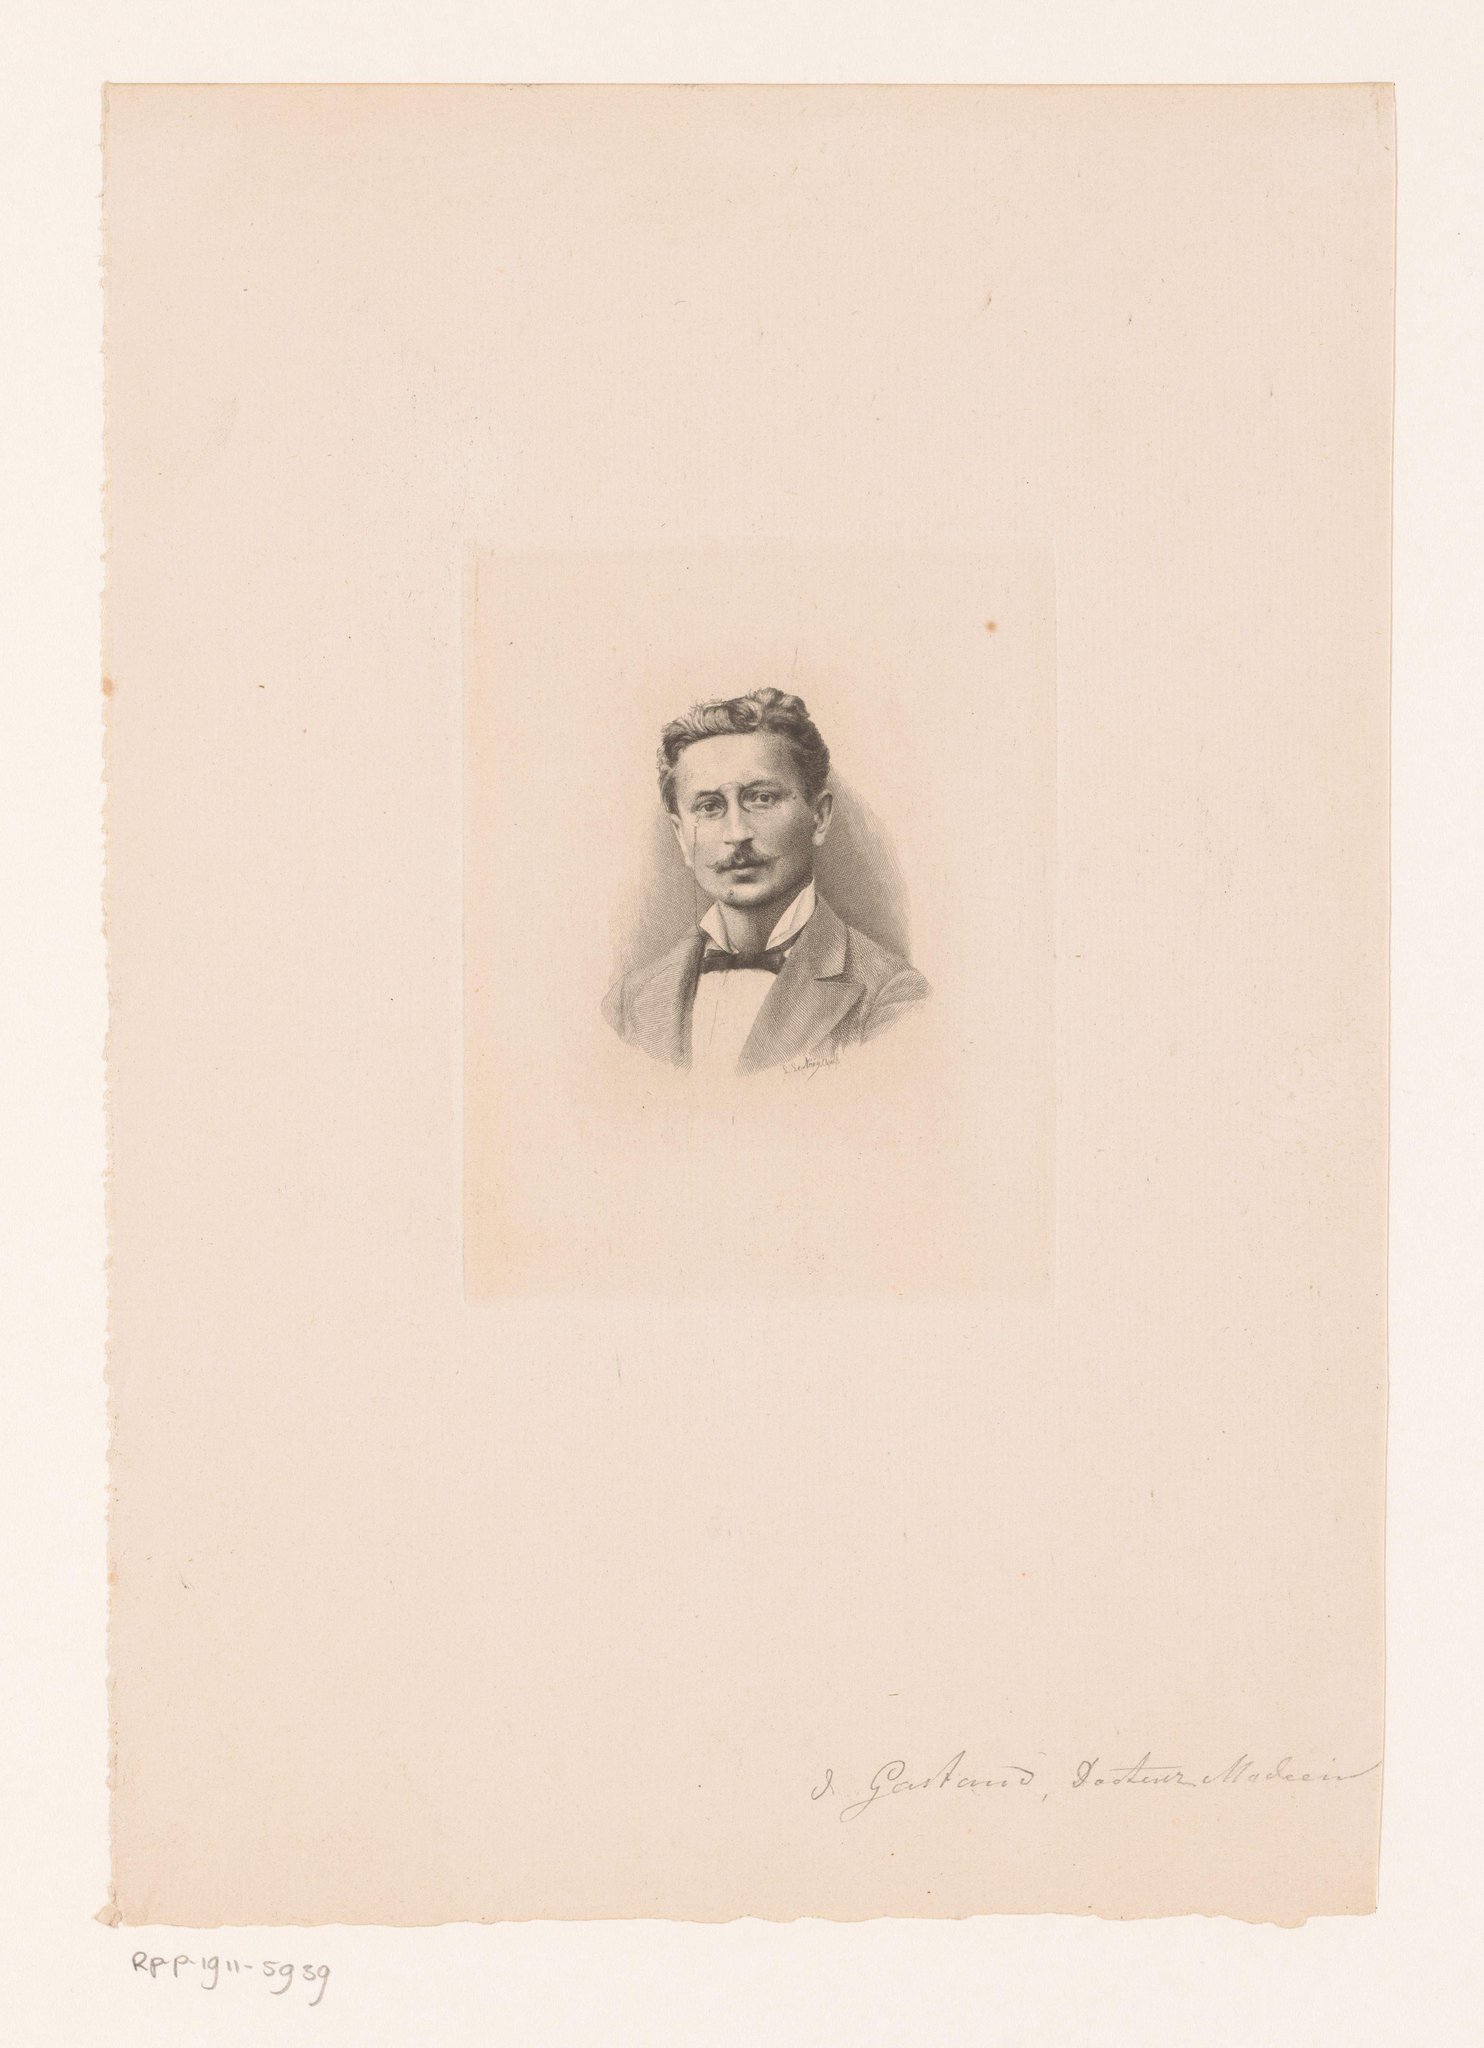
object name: print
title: Portret van een onbekende man, mogelijk Dr. de Gastaud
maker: louis le nain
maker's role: print maker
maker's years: 1851-1939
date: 1861-1911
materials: paper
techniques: etching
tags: eyeglasses, spectacles, adult man, historical persons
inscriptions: collector's mark: Lugt 2228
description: Opschrift in potlood op object: Gastaud, docteur medicin.